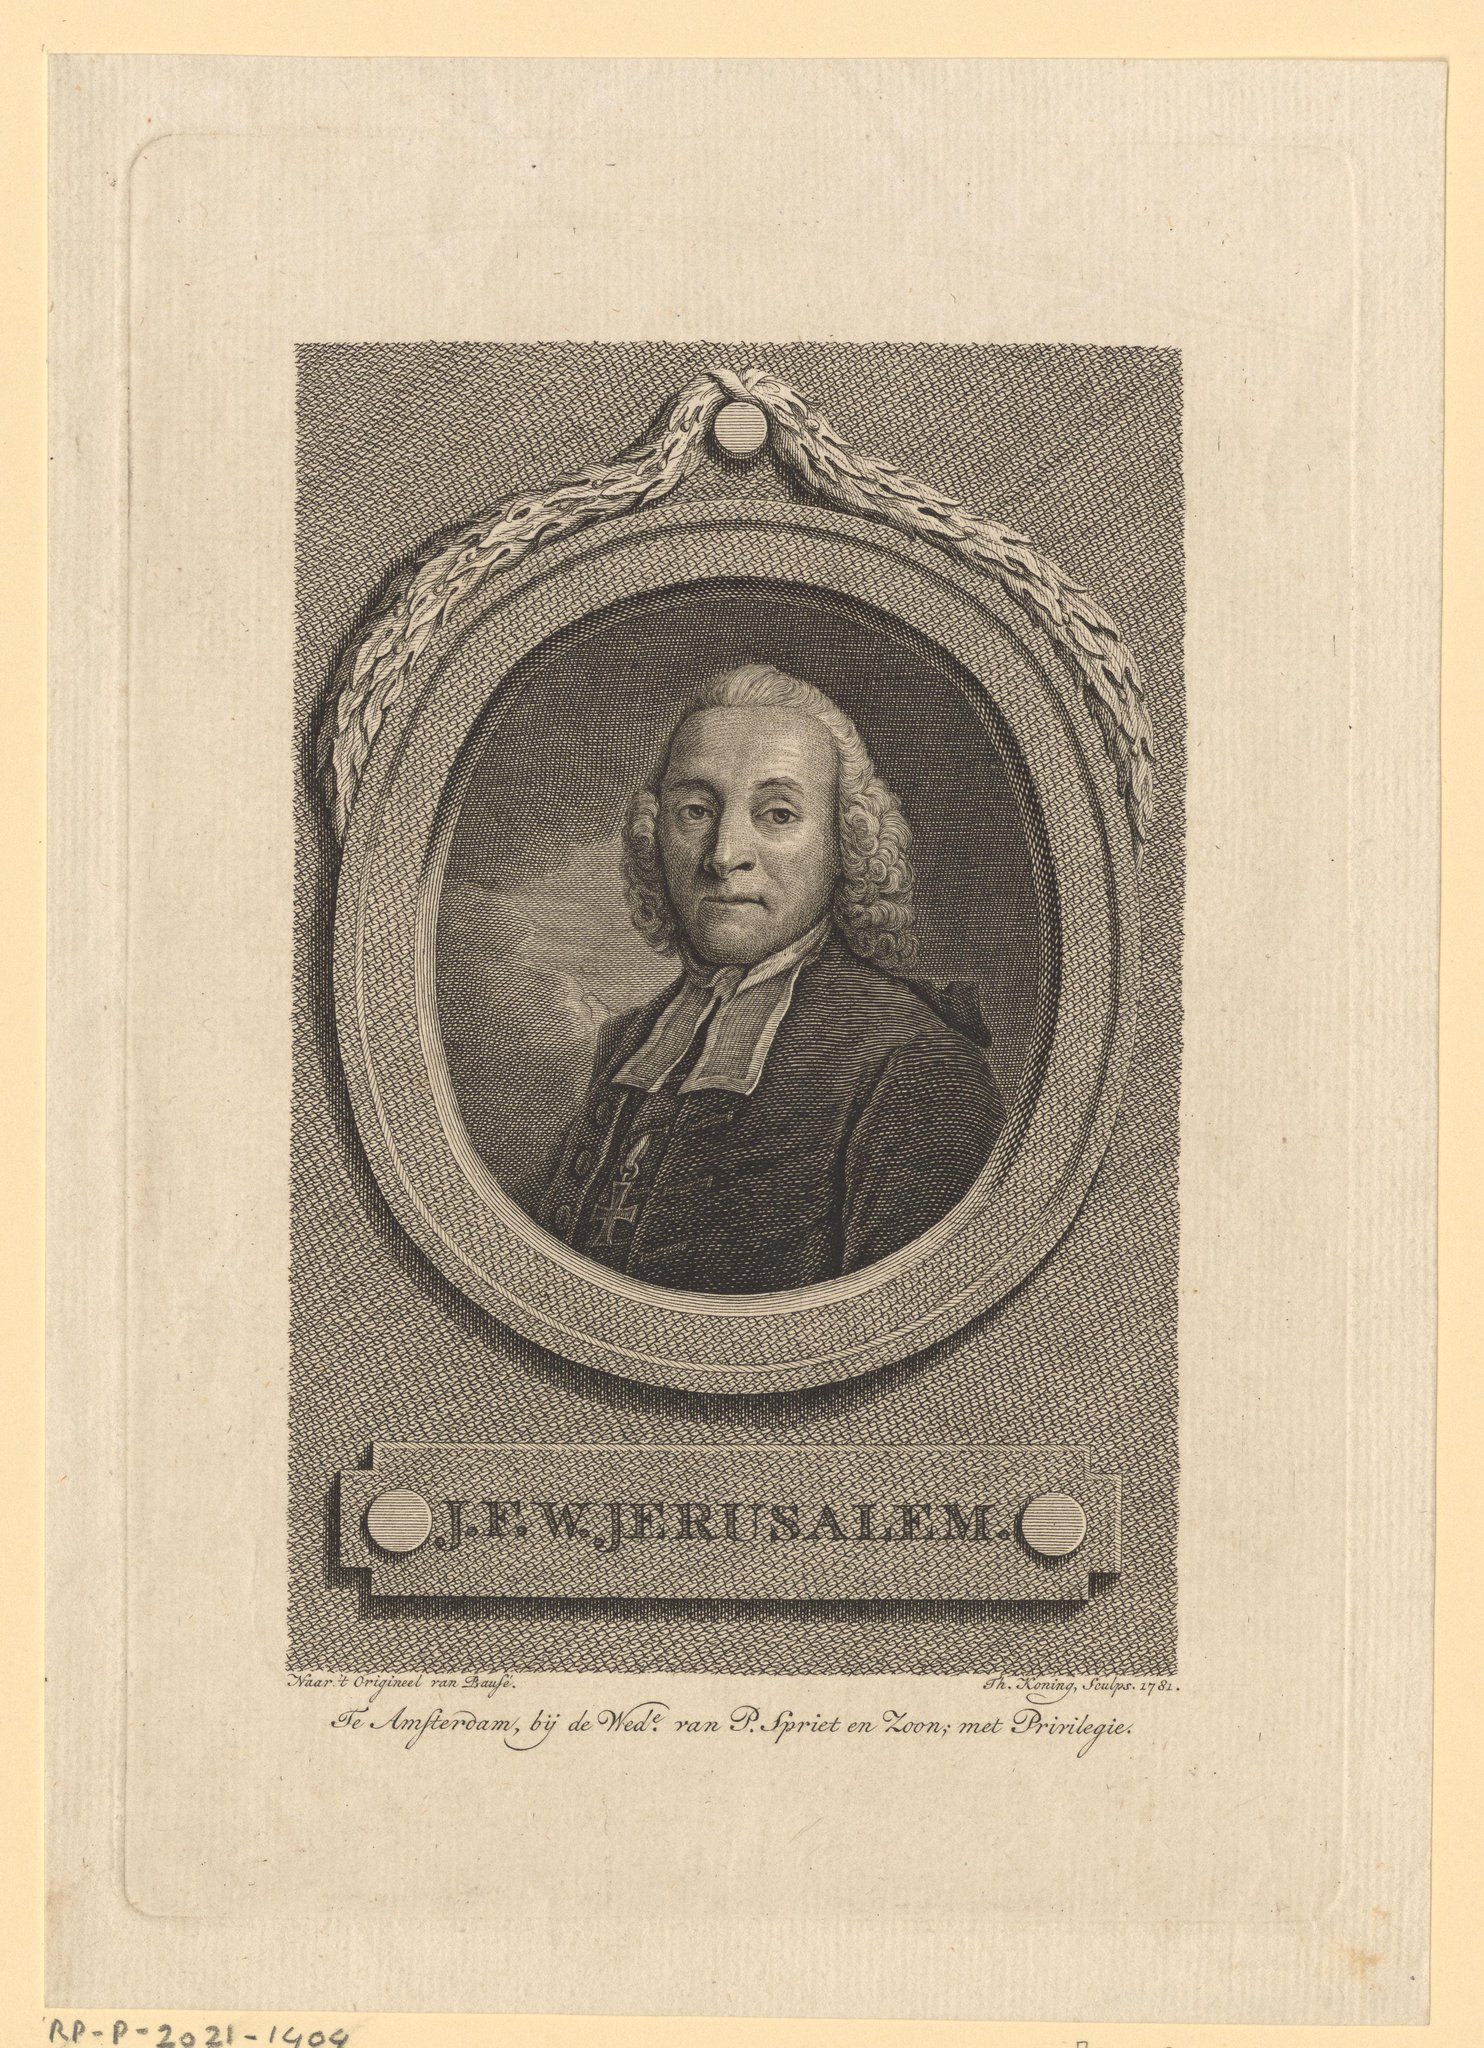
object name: print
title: Portret van Johann Friedrich Wilhelm Jerusalem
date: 1781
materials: paper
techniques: engraving, etching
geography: amsterdam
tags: theologian, historical persons